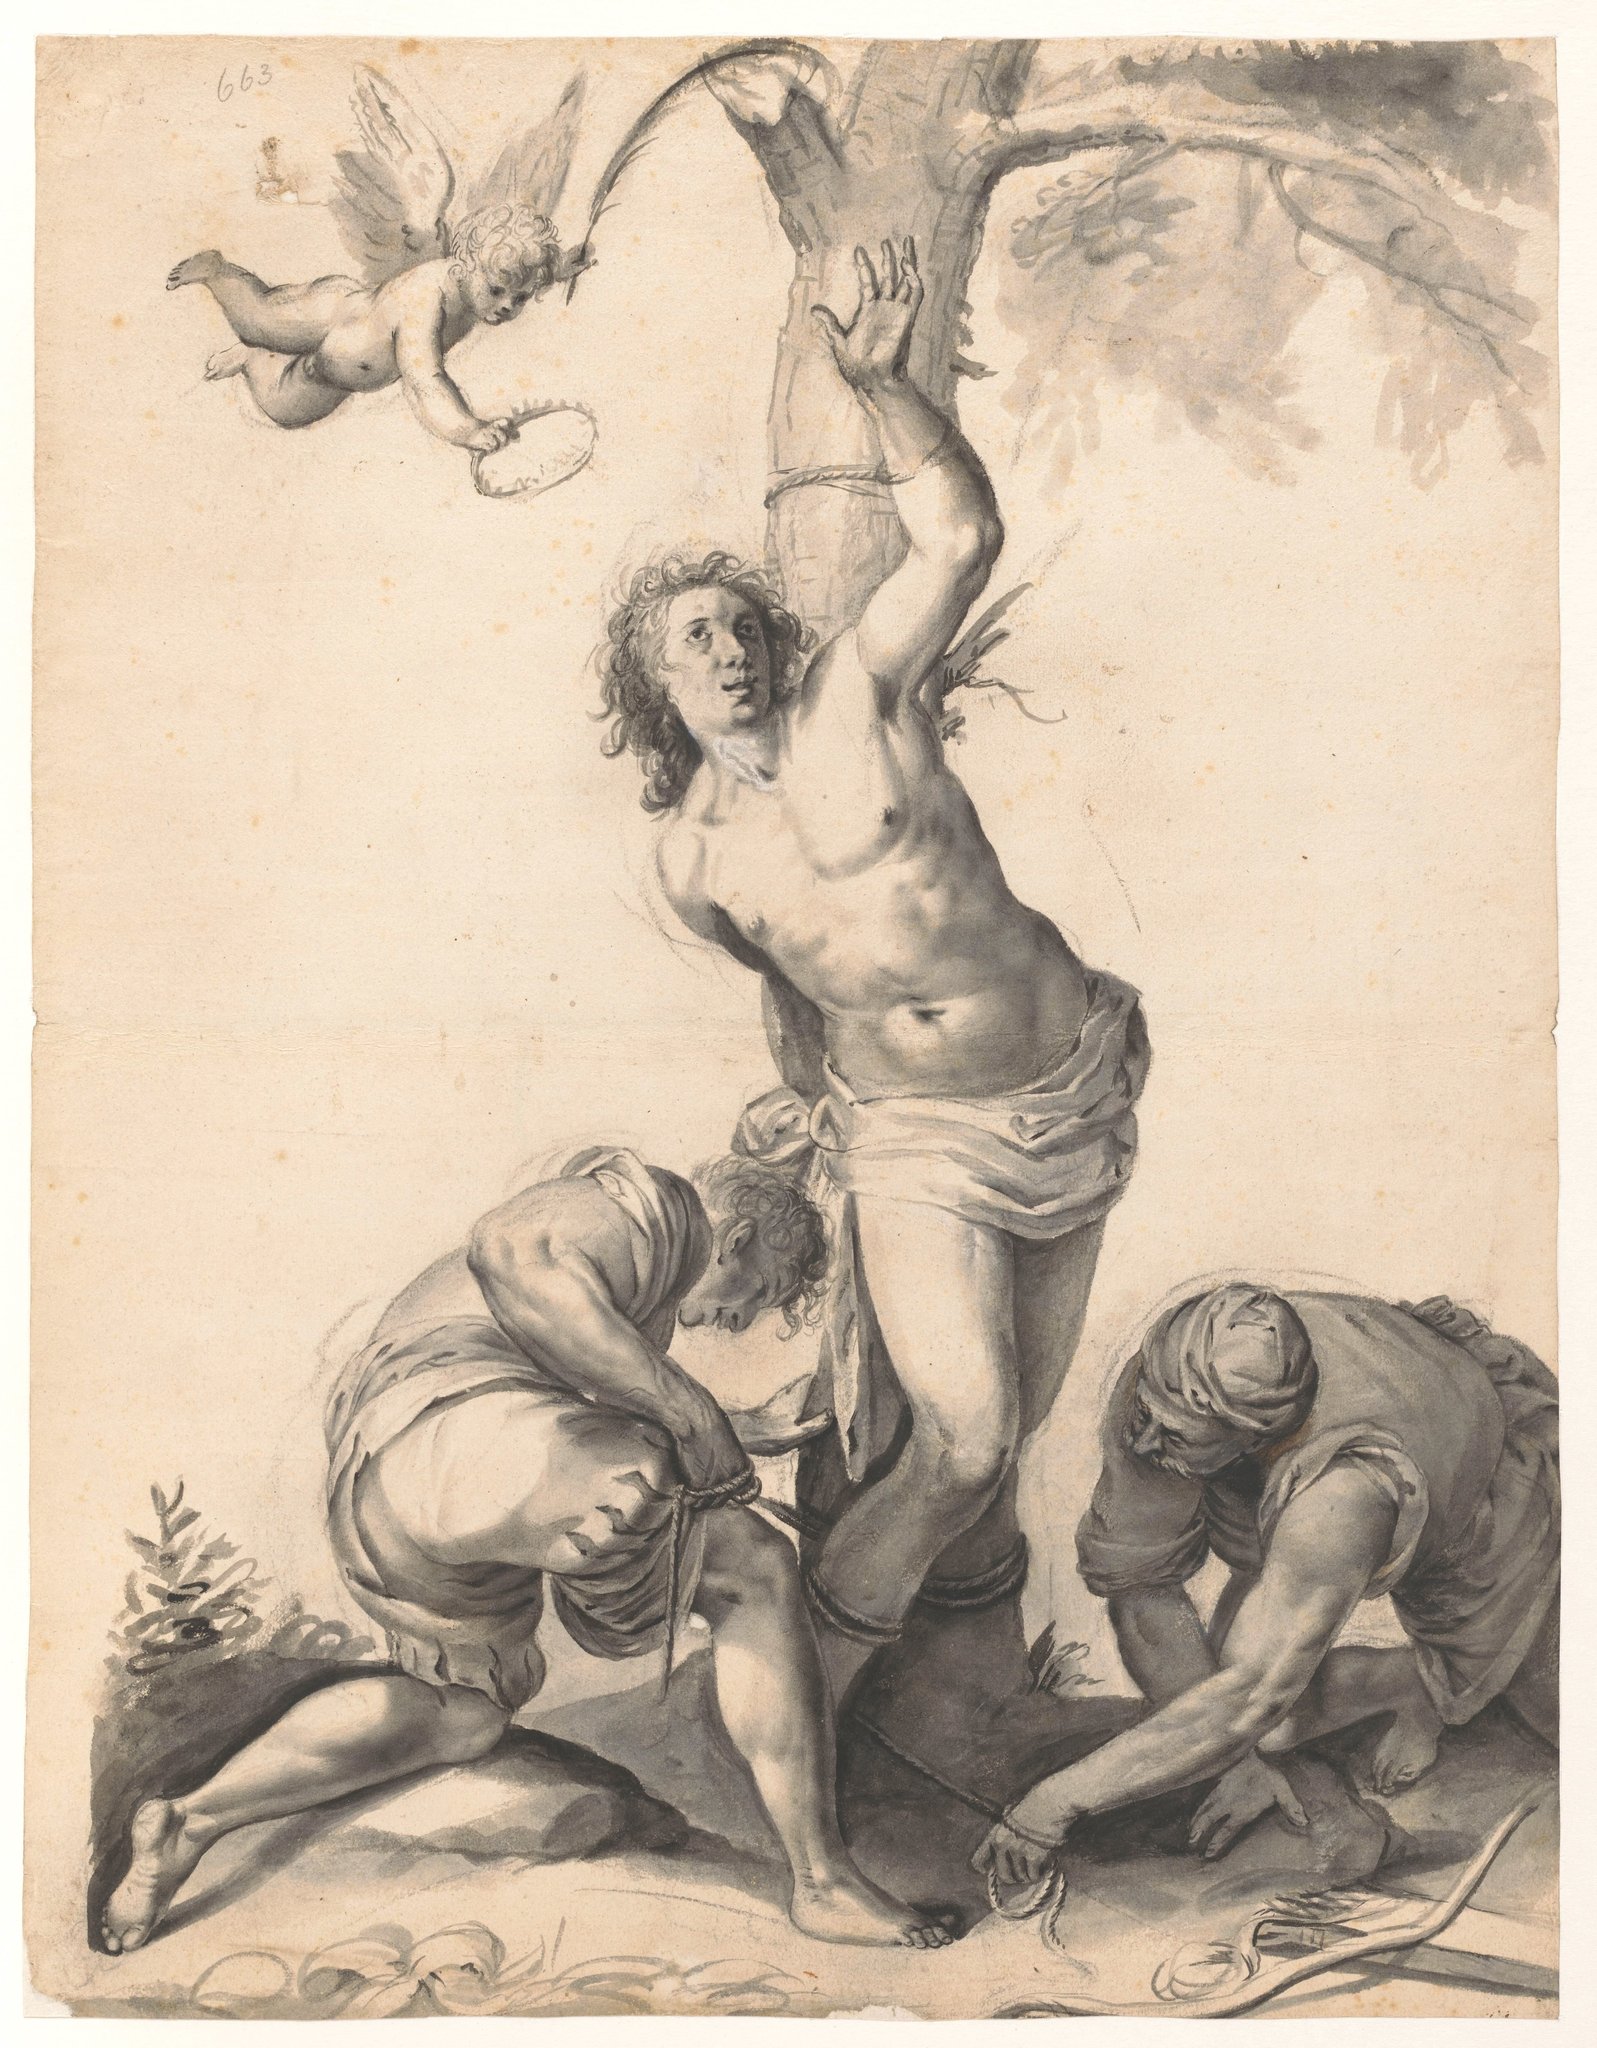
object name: drawing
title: Het martelaarschap van de Heilige Sebastiaan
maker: moses ter borch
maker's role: draughtsman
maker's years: 1645-1667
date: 1660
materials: chalk, paint, gouache, ink, paper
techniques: brush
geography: zwolle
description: Kopie naar gravure van A. Sadeler uit 1621 naar ontwerp van Jacopo Palma (Holl.96).